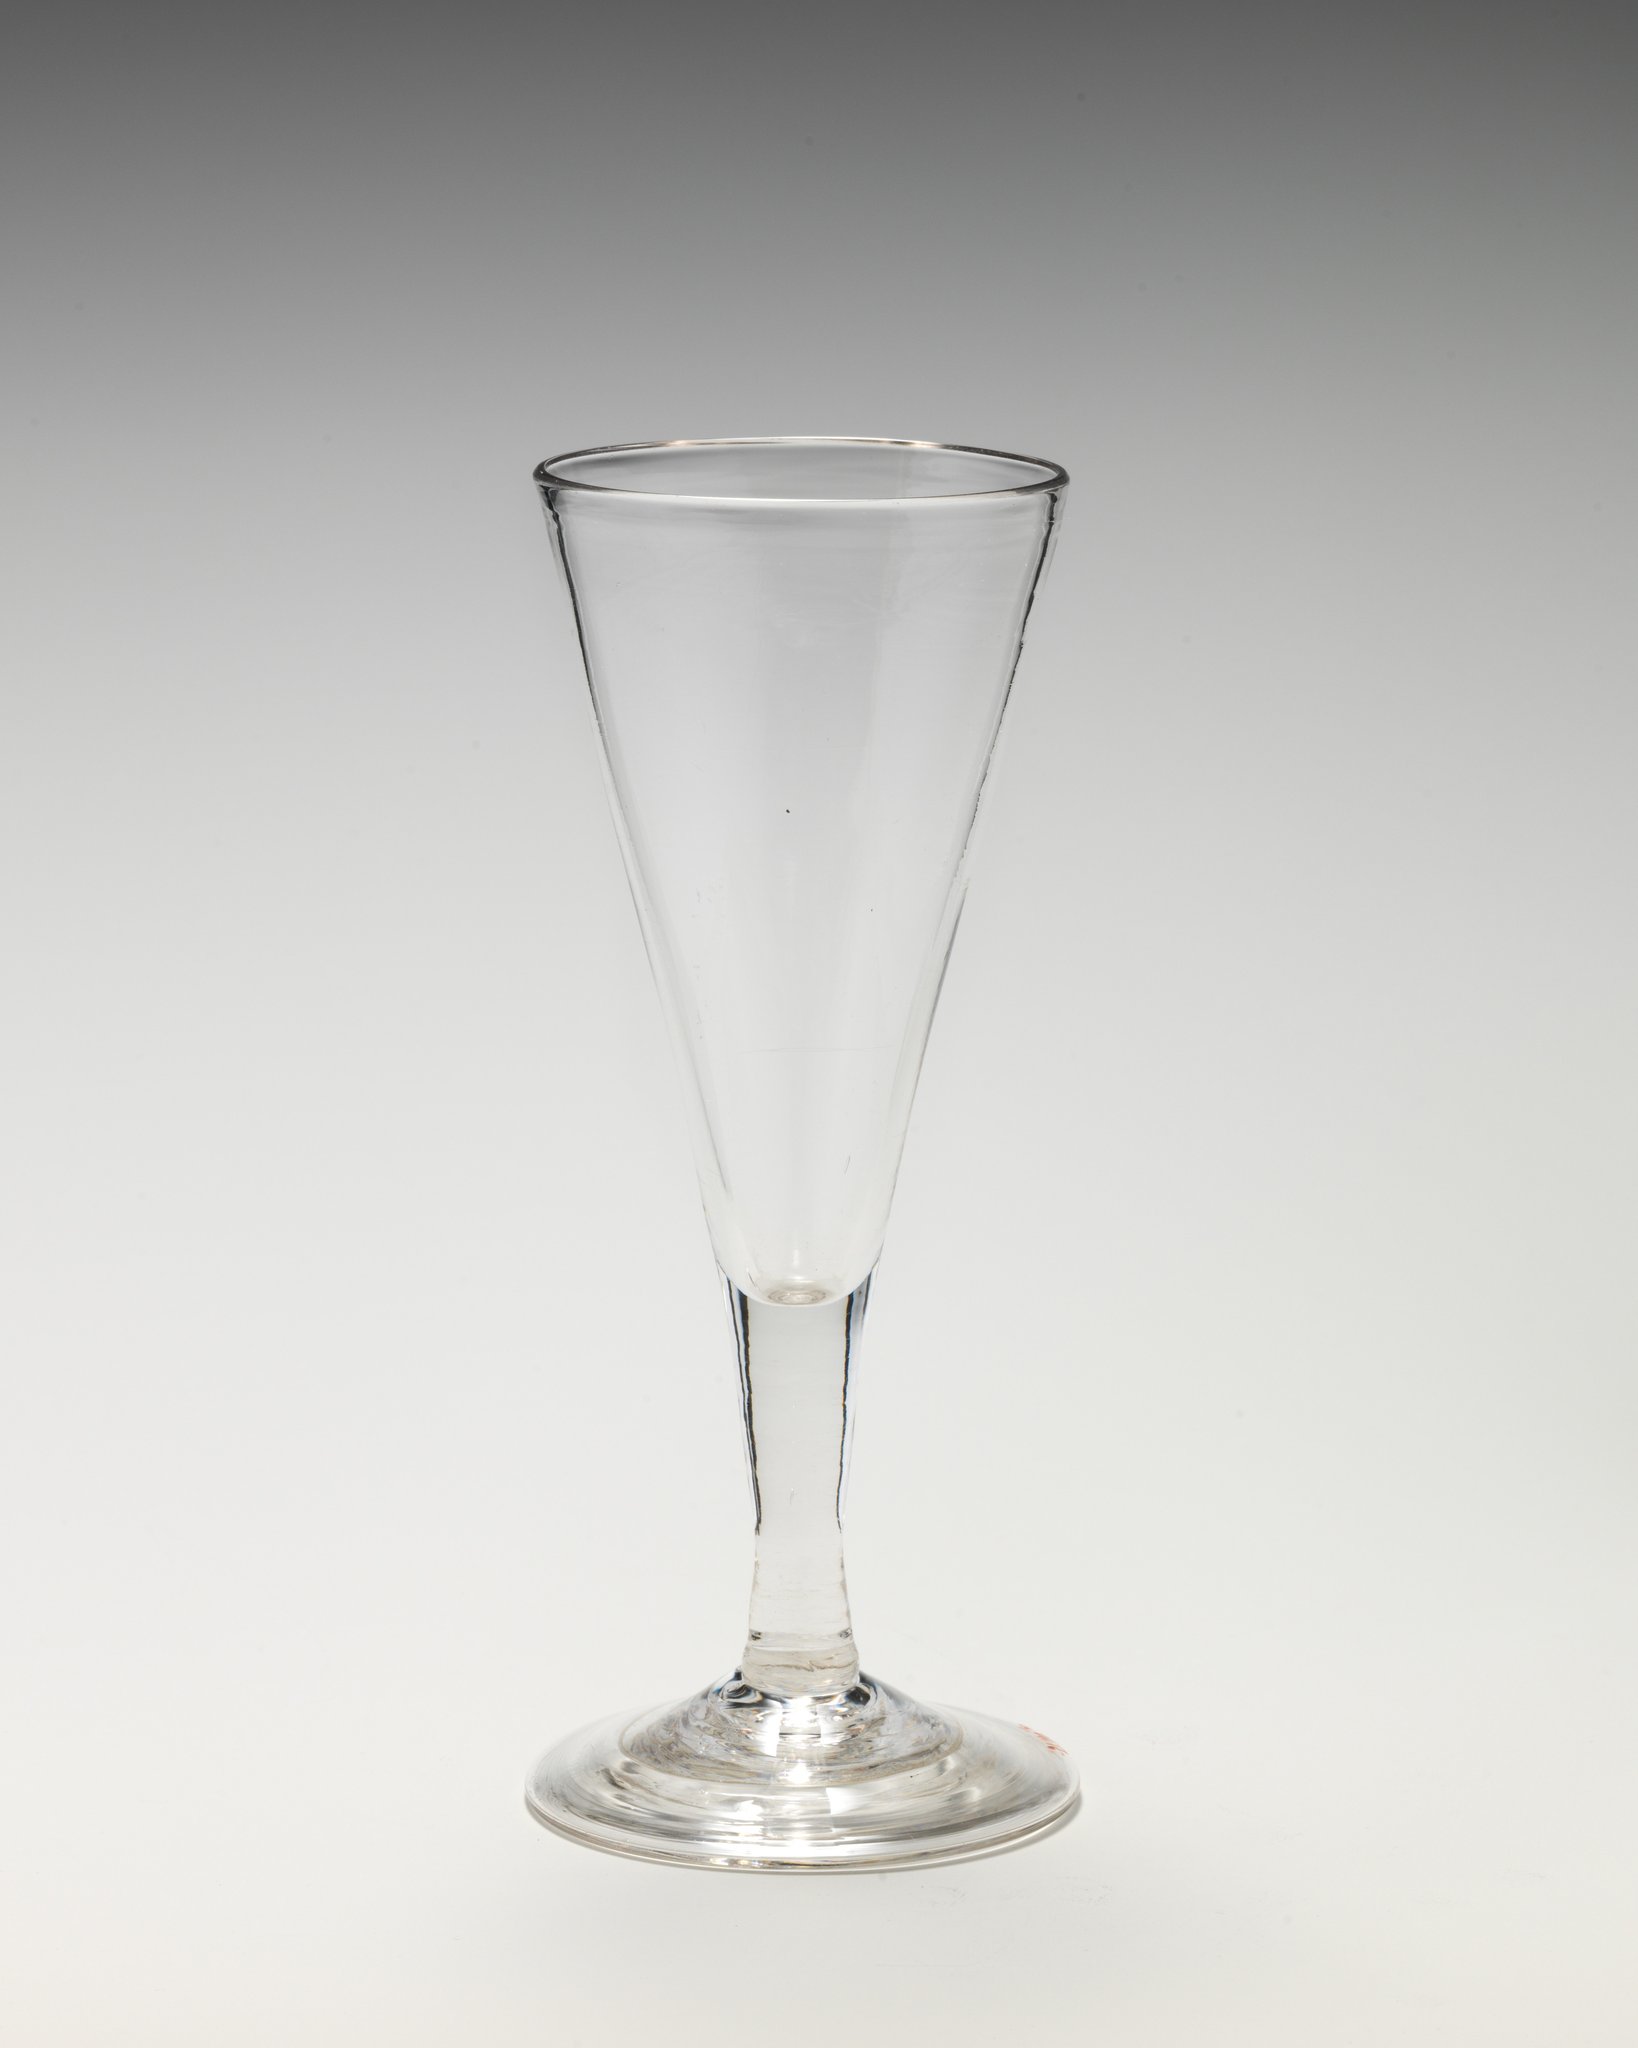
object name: champagne glass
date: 1735-1760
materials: glass